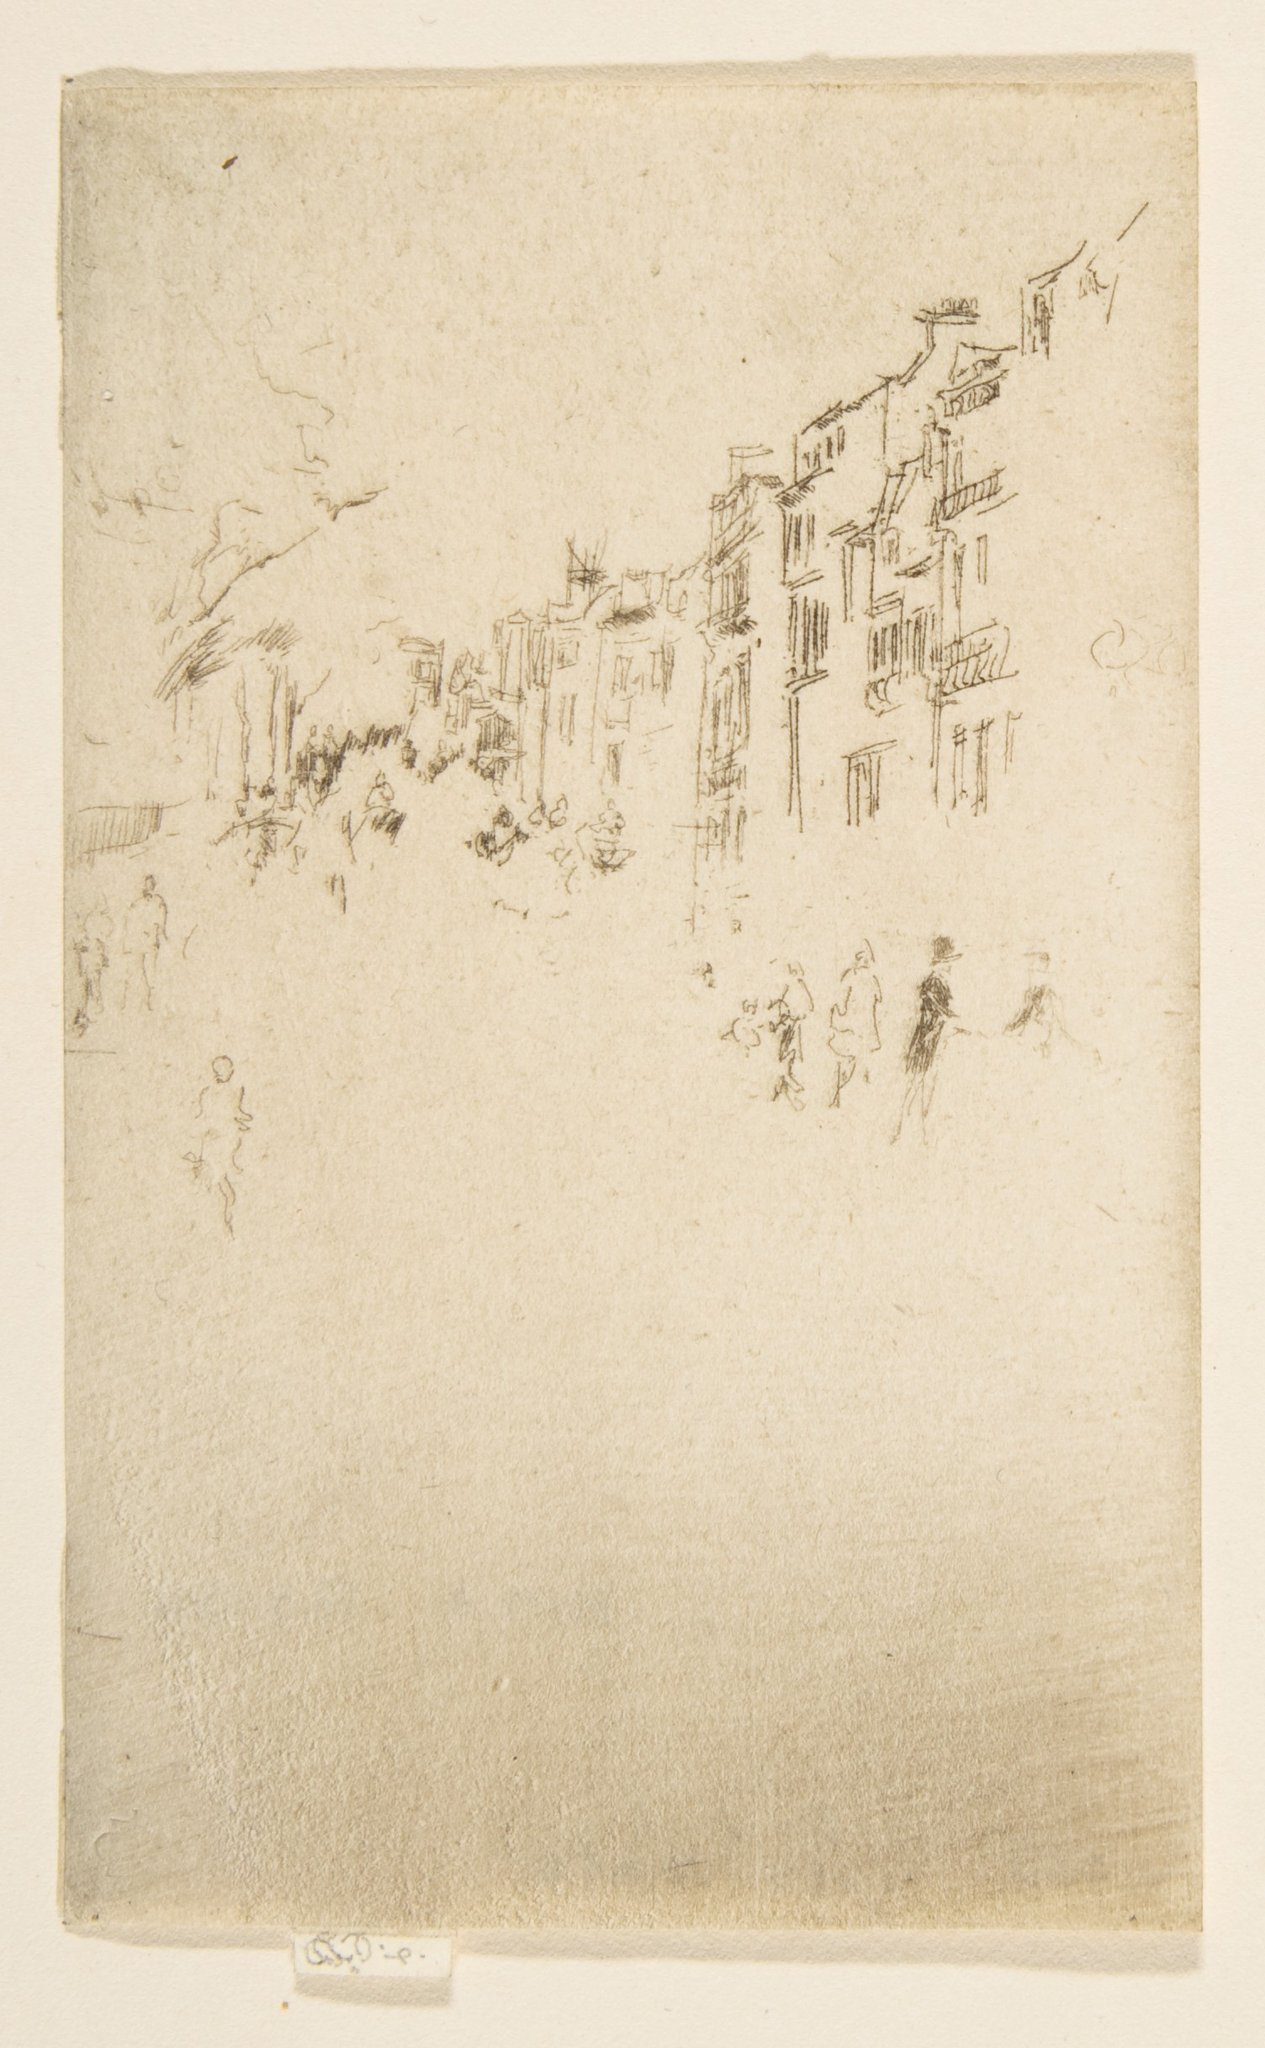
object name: print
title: A Fragment of Piccadilly (Piccadilly)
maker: james mcneill whistler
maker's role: artist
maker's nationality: american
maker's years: 1834-1903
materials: ink, paper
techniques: etching, printing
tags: buildings